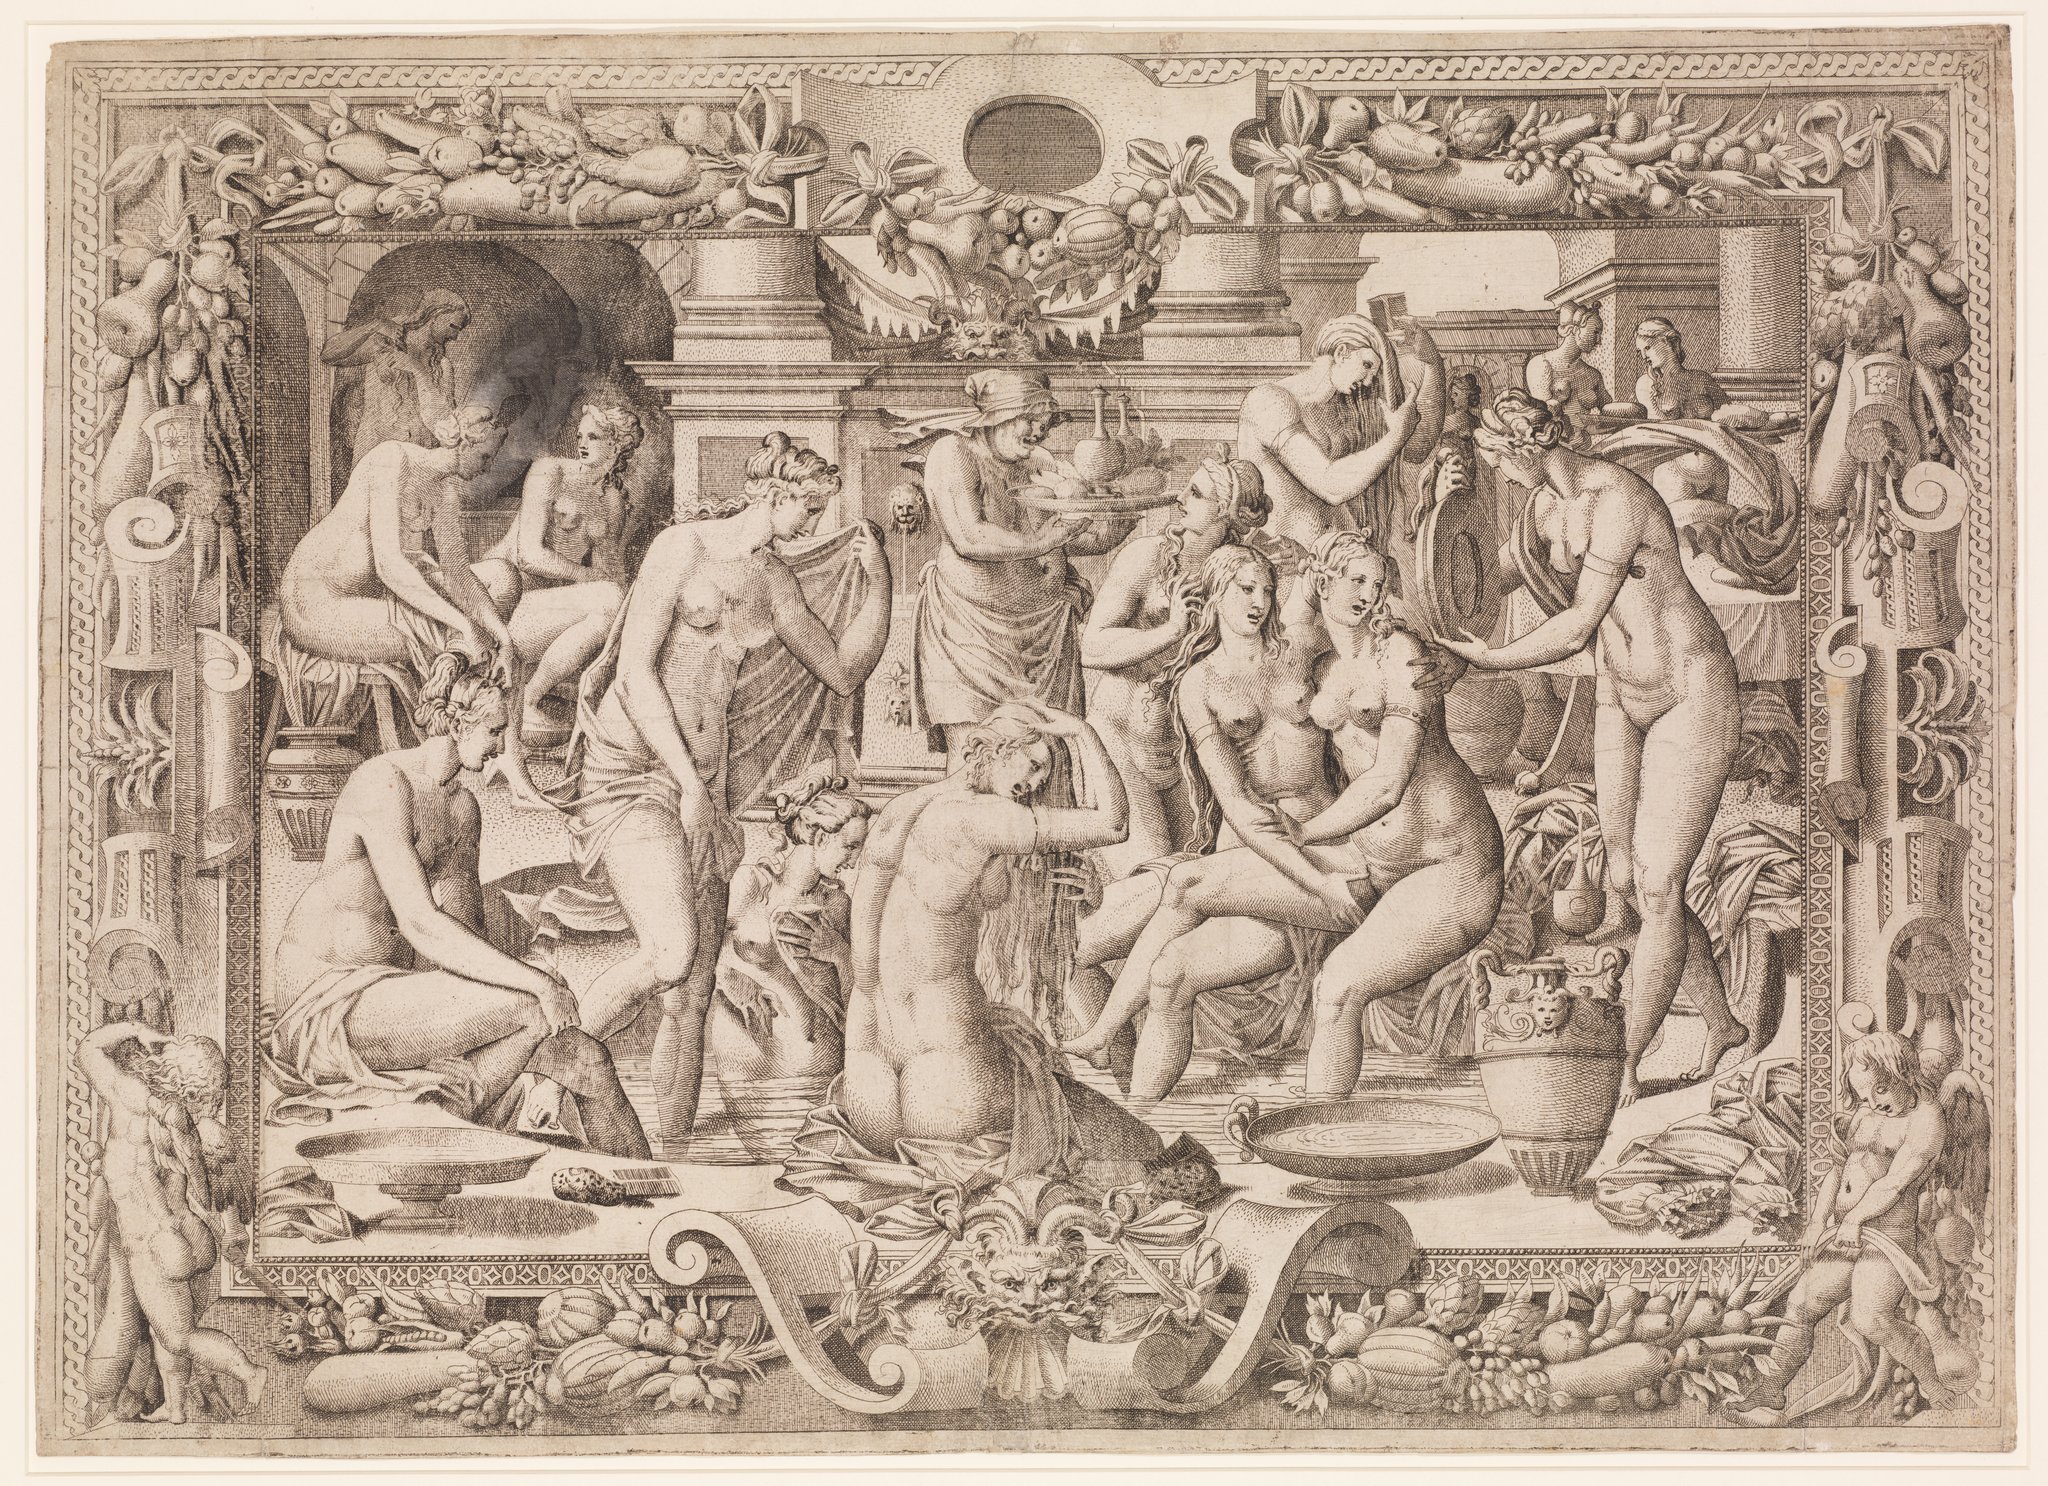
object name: print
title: Women Bathing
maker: jean mignon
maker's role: artist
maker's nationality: french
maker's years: 1535-1555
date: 1535-1555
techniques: etching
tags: fruit,female nudes,bathing